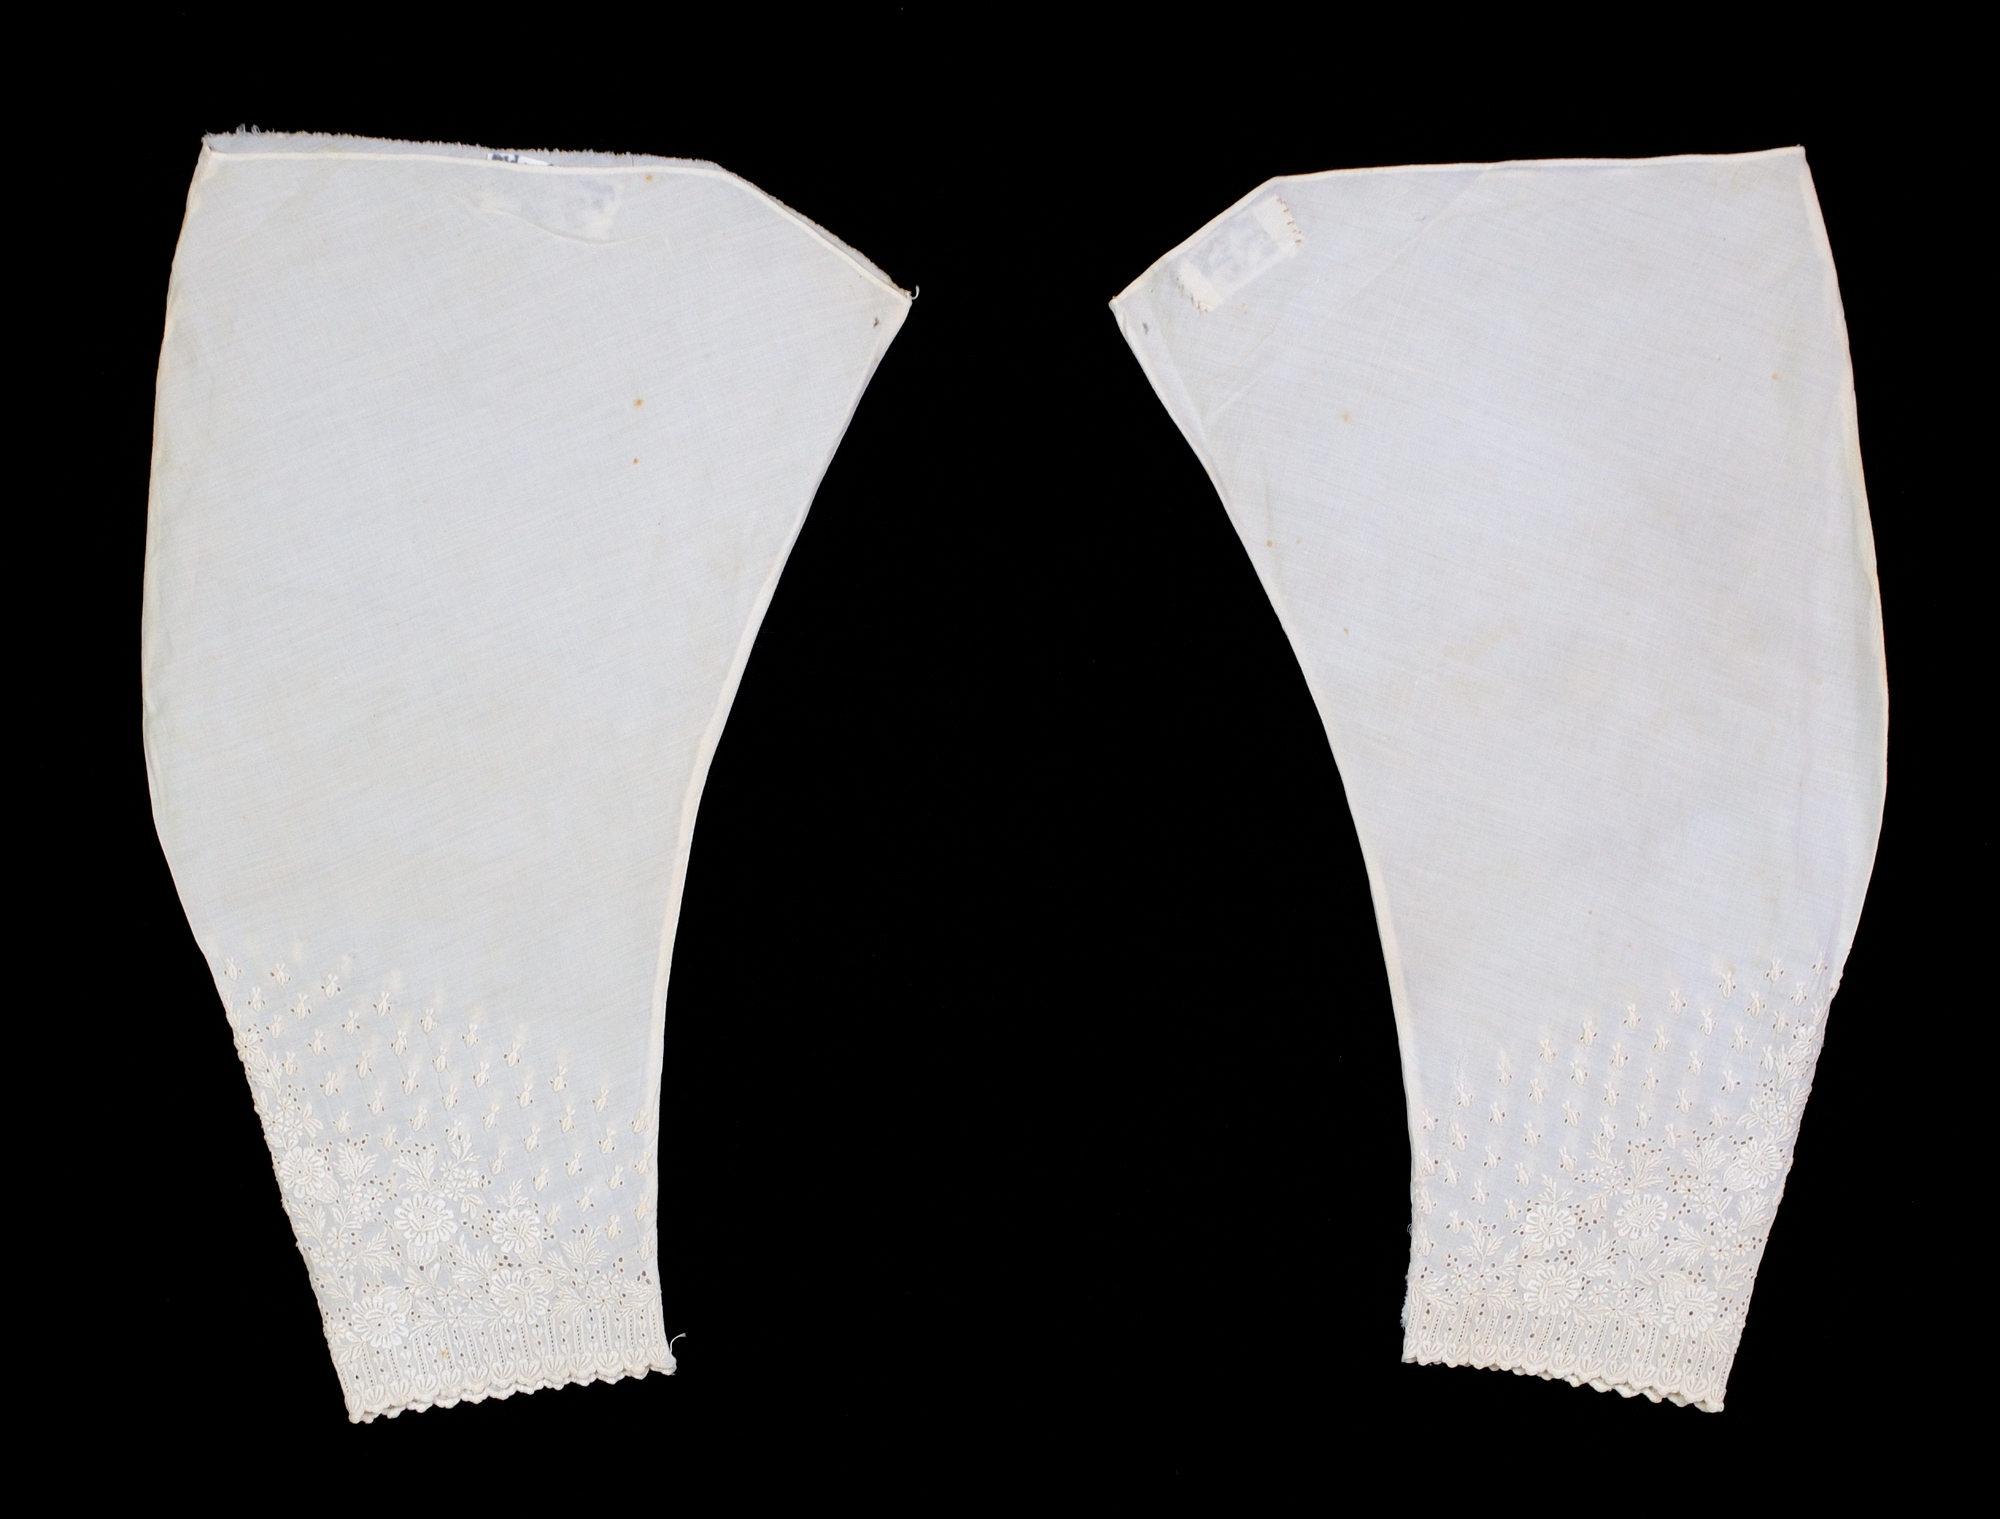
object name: undersleeves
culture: american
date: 1826-1850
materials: cotton